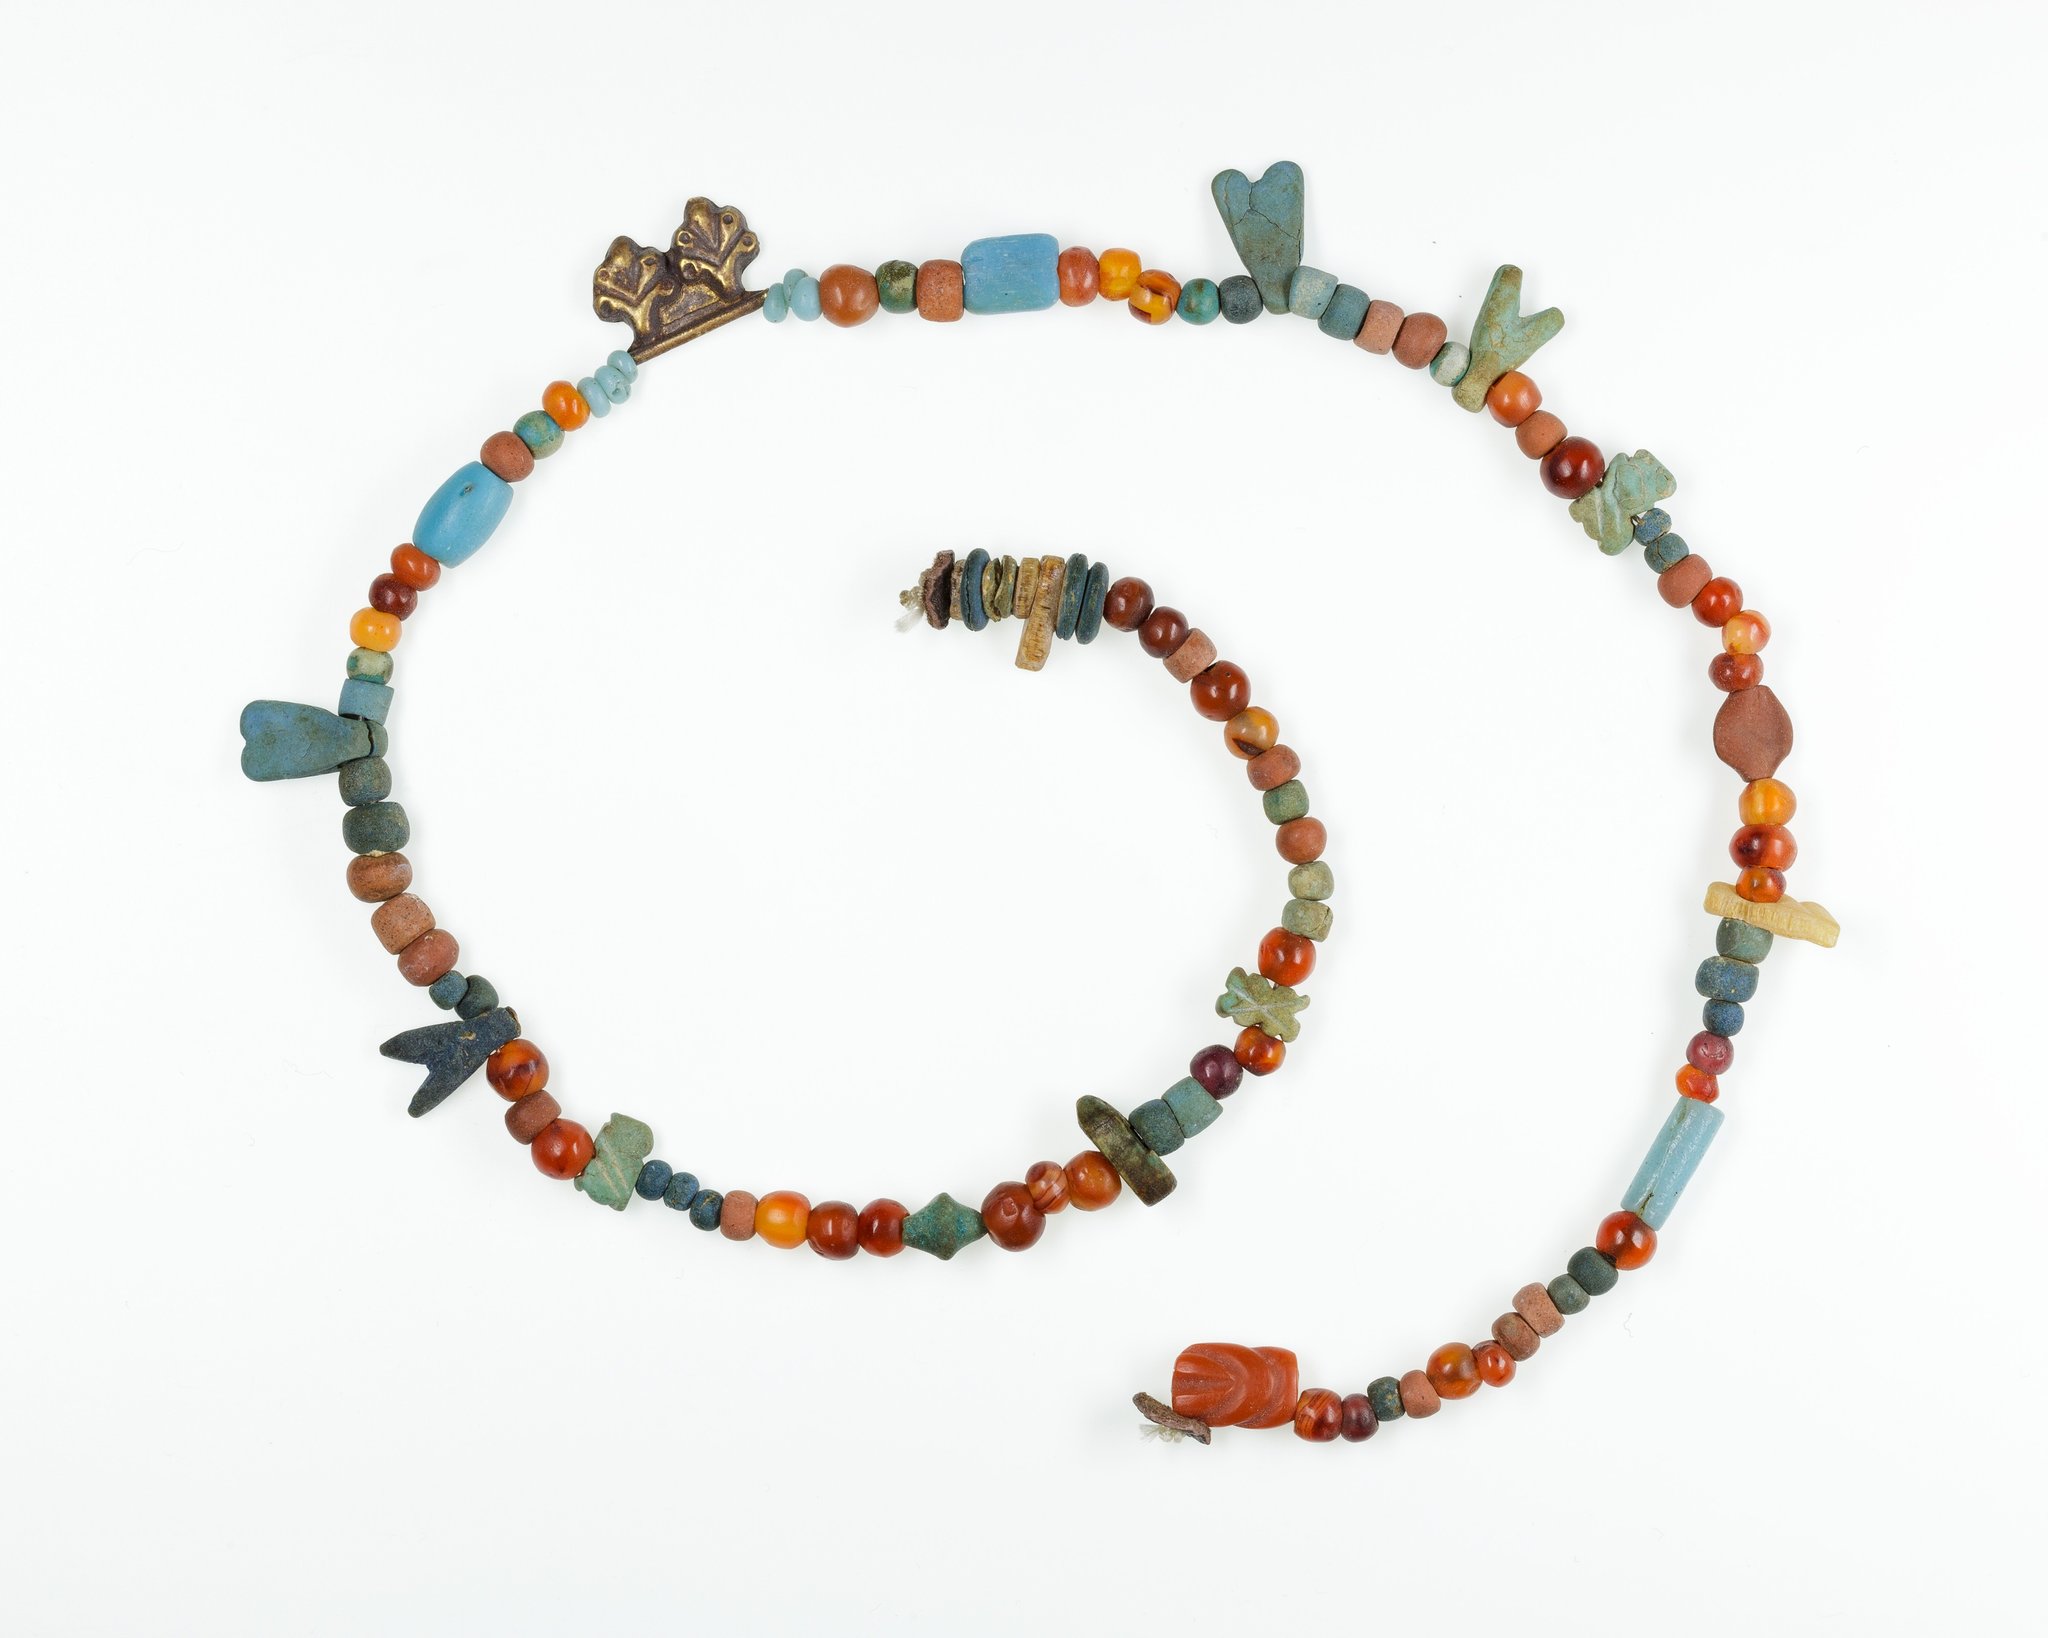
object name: necklace, fly amulet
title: Necklace with fly amulets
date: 1786-1482 BCE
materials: faience, gold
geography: egypt